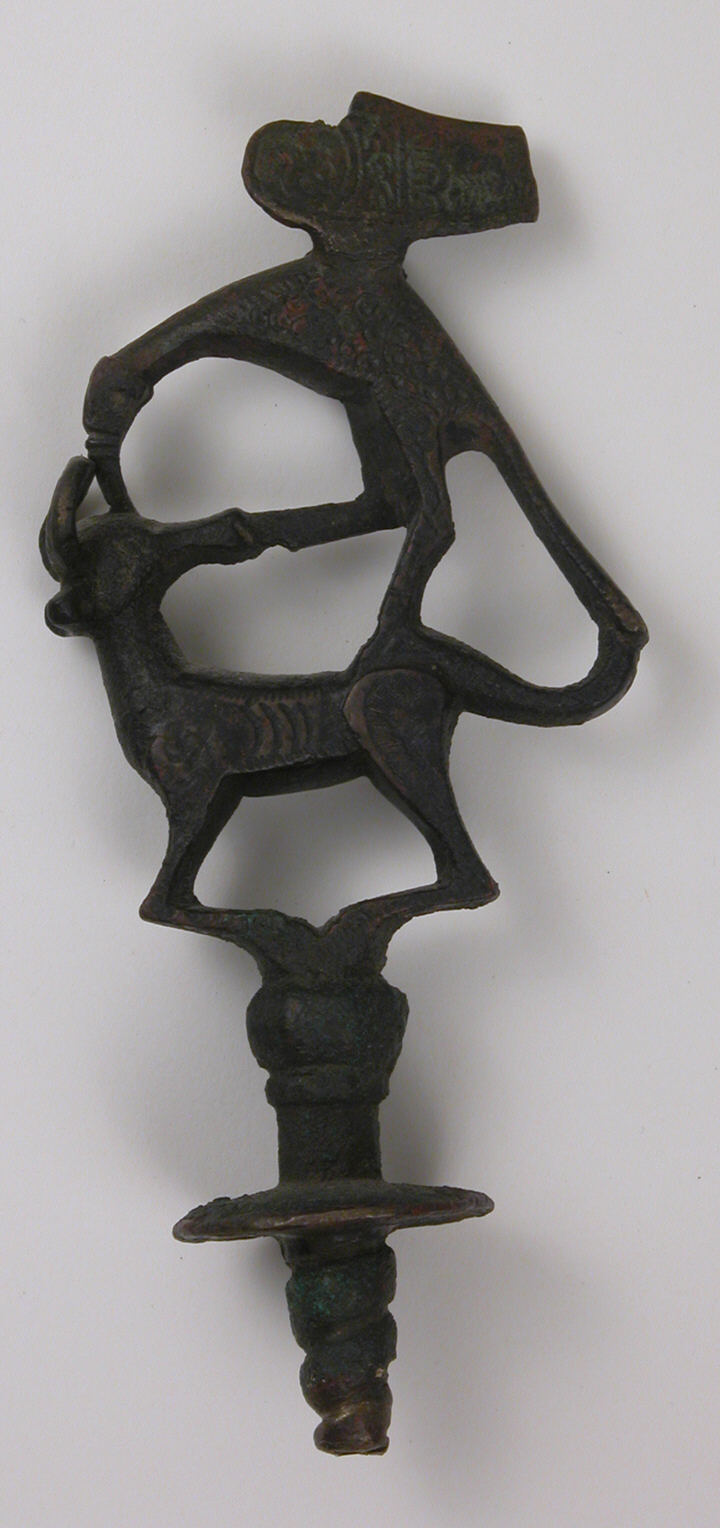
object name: ornament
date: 1001-1200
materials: bronze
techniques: casting, engraving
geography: egypt